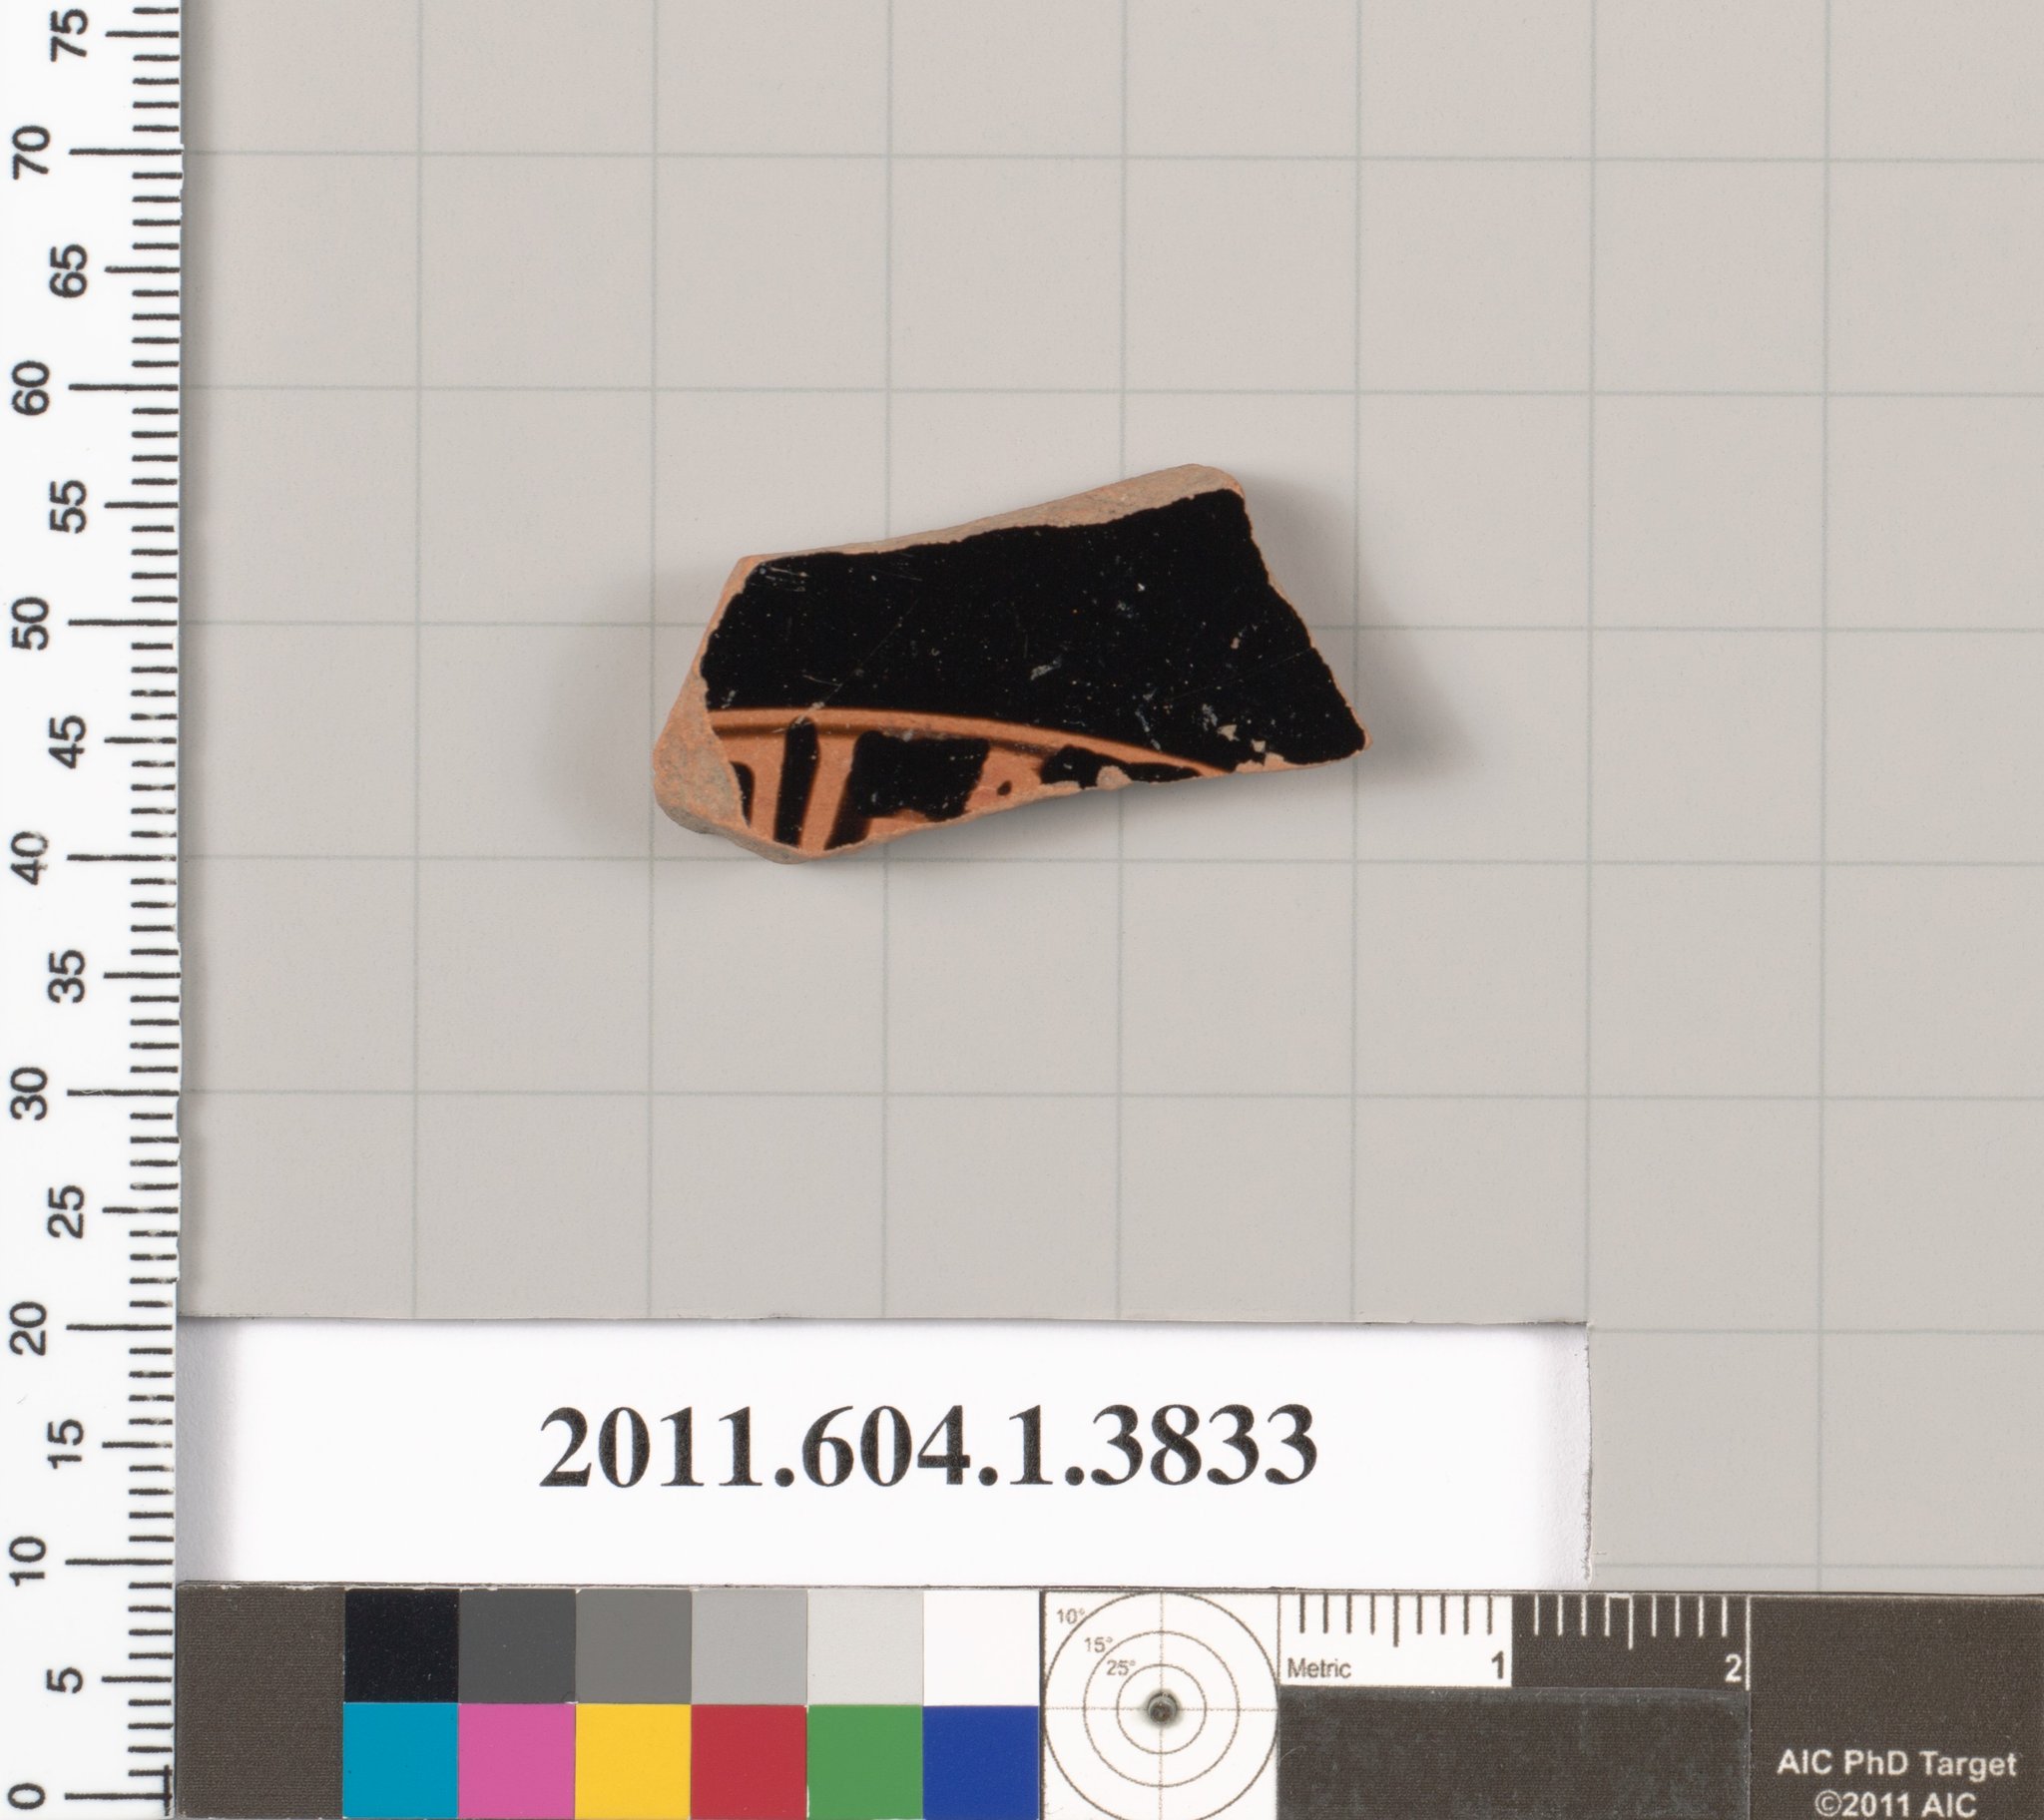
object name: kylix fragment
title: Terracotta fragment of a kylix (drinking cup)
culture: greek, attic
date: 475-451 BCE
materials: terracotta